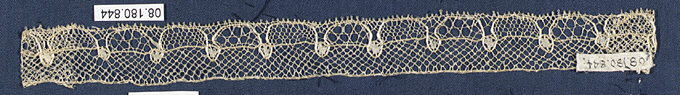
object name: piece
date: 1801-1900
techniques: lace